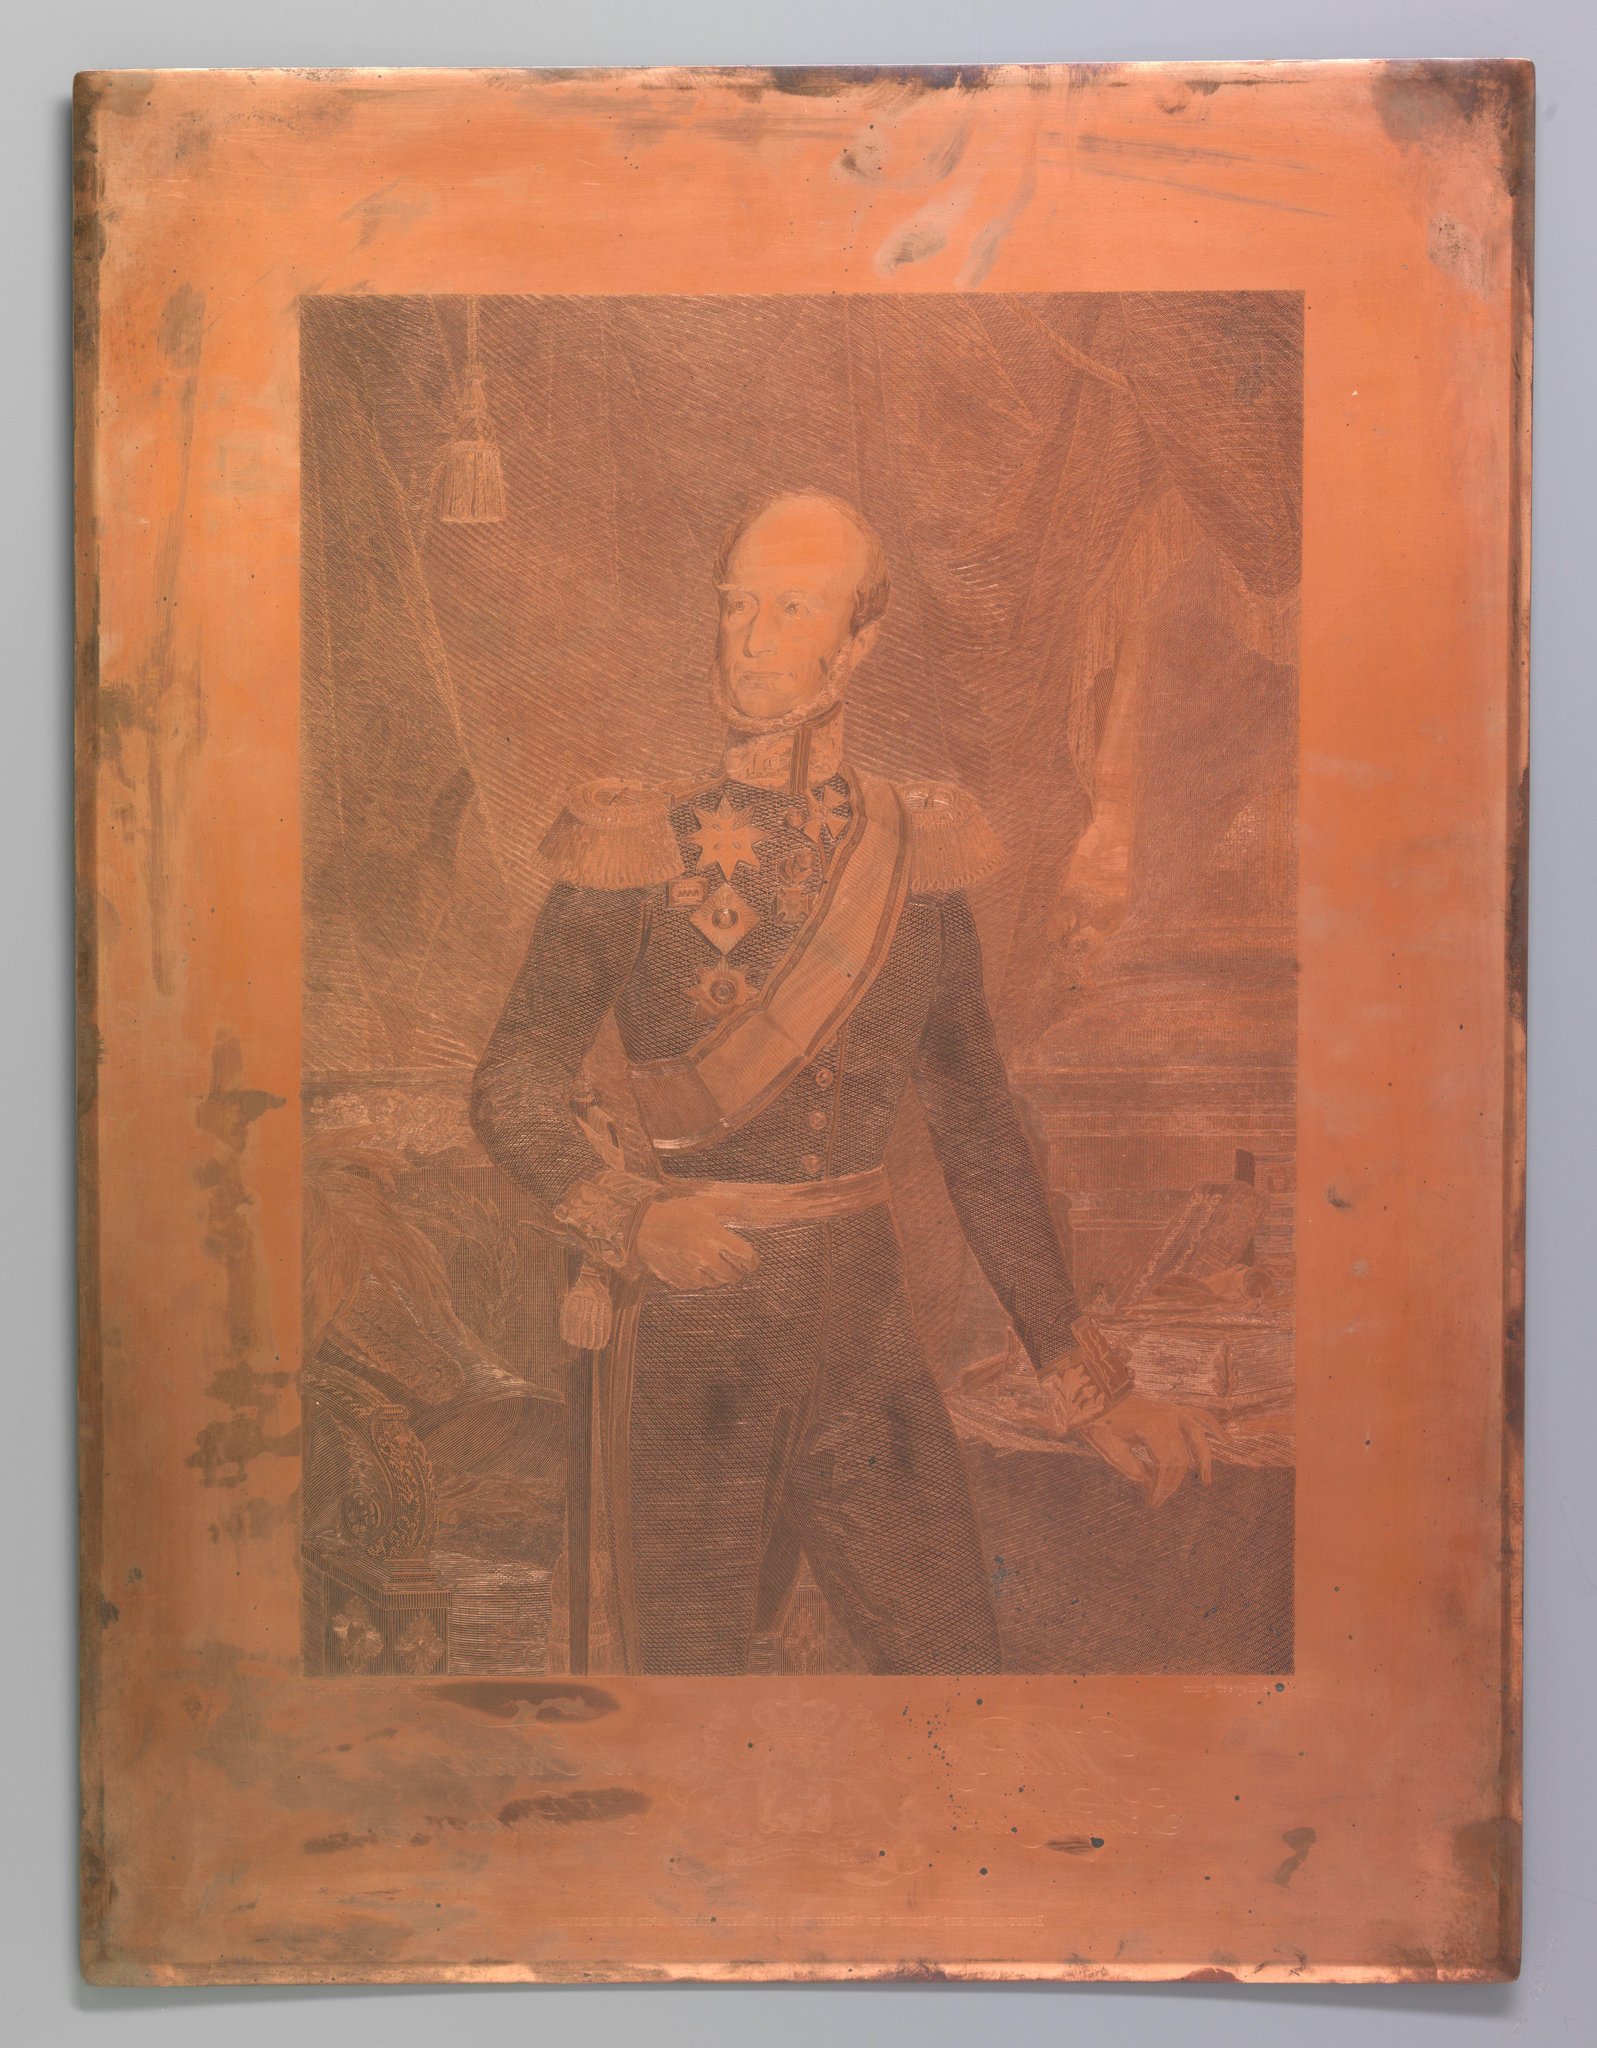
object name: copper plate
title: Portret van Willem II, koning der Nederlanden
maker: michel charles antoine verswyvel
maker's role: print maker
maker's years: 1819-1868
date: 1840-1868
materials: copper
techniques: engraving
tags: the hague, william ii of the netherlands